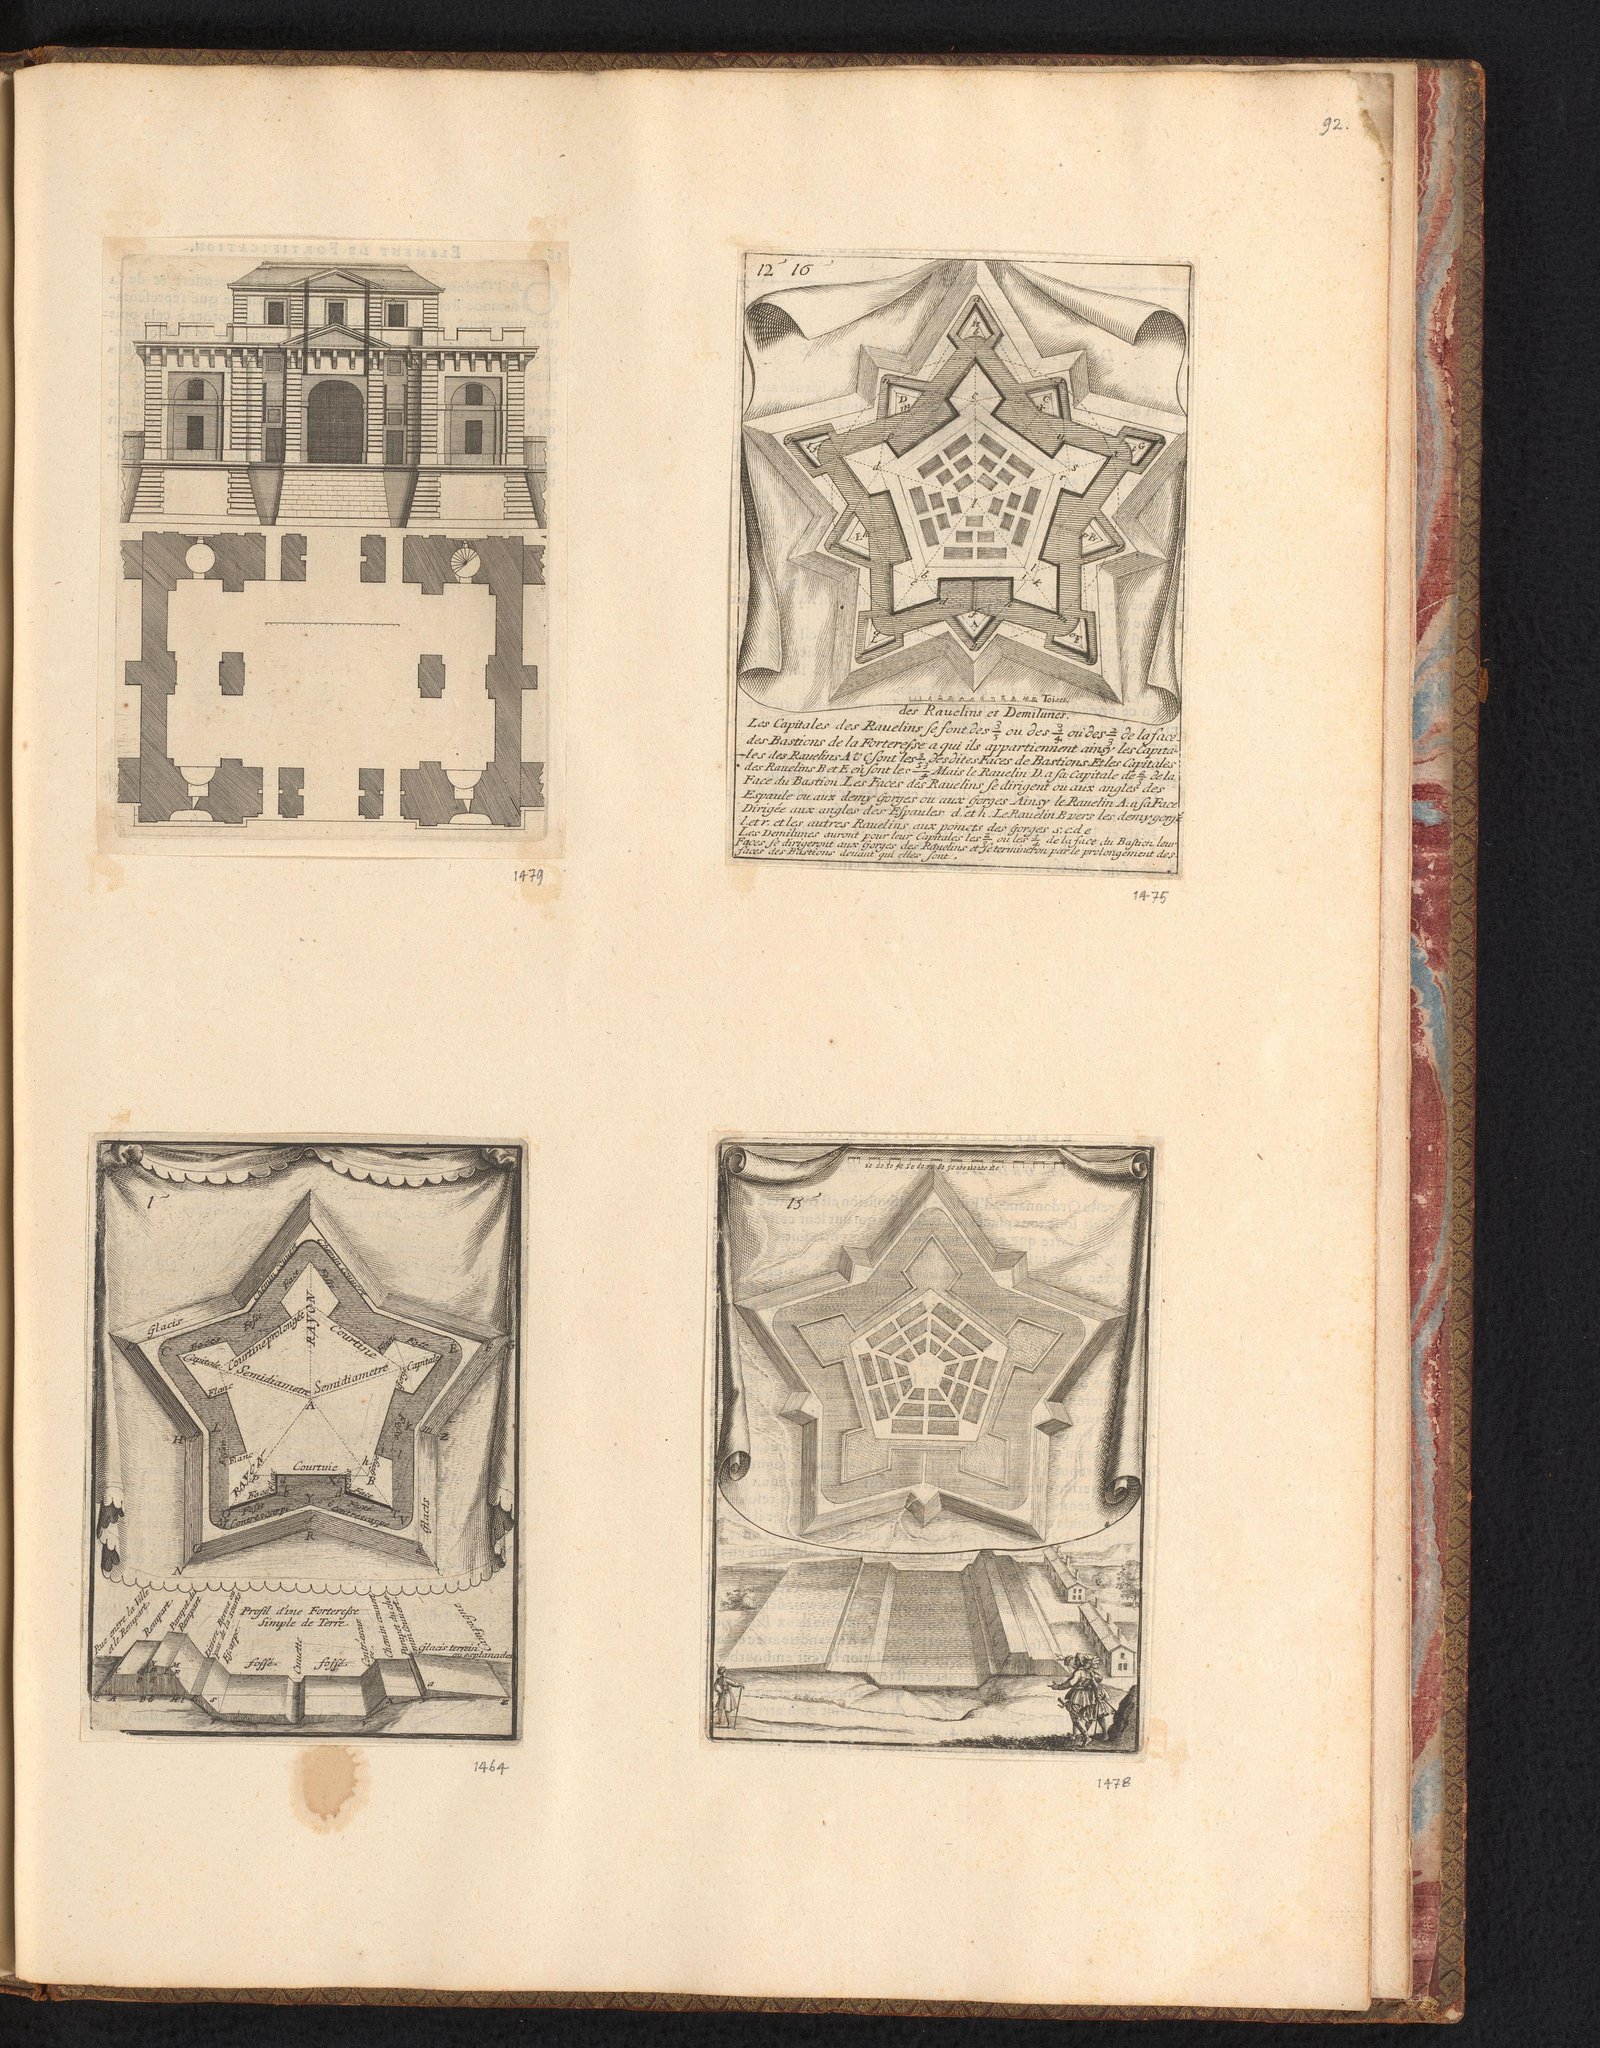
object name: book illustration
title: Verstevigde poort en plattegronden van vestingsteden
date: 1666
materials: paper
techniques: etching, letterpress printing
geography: paris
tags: gate ~ fortified city, fortified city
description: Prenten uit: Brioys, Jean. Nouvelle maniere de fortification (...). Parijs: François Collignon, 1666.